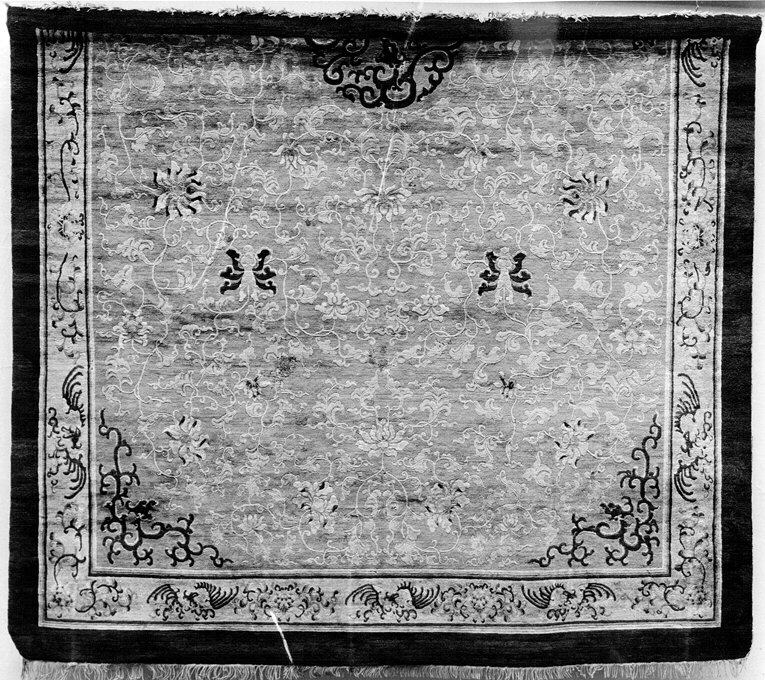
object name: rug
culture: chinese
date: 1644-1911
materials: cotton, wool